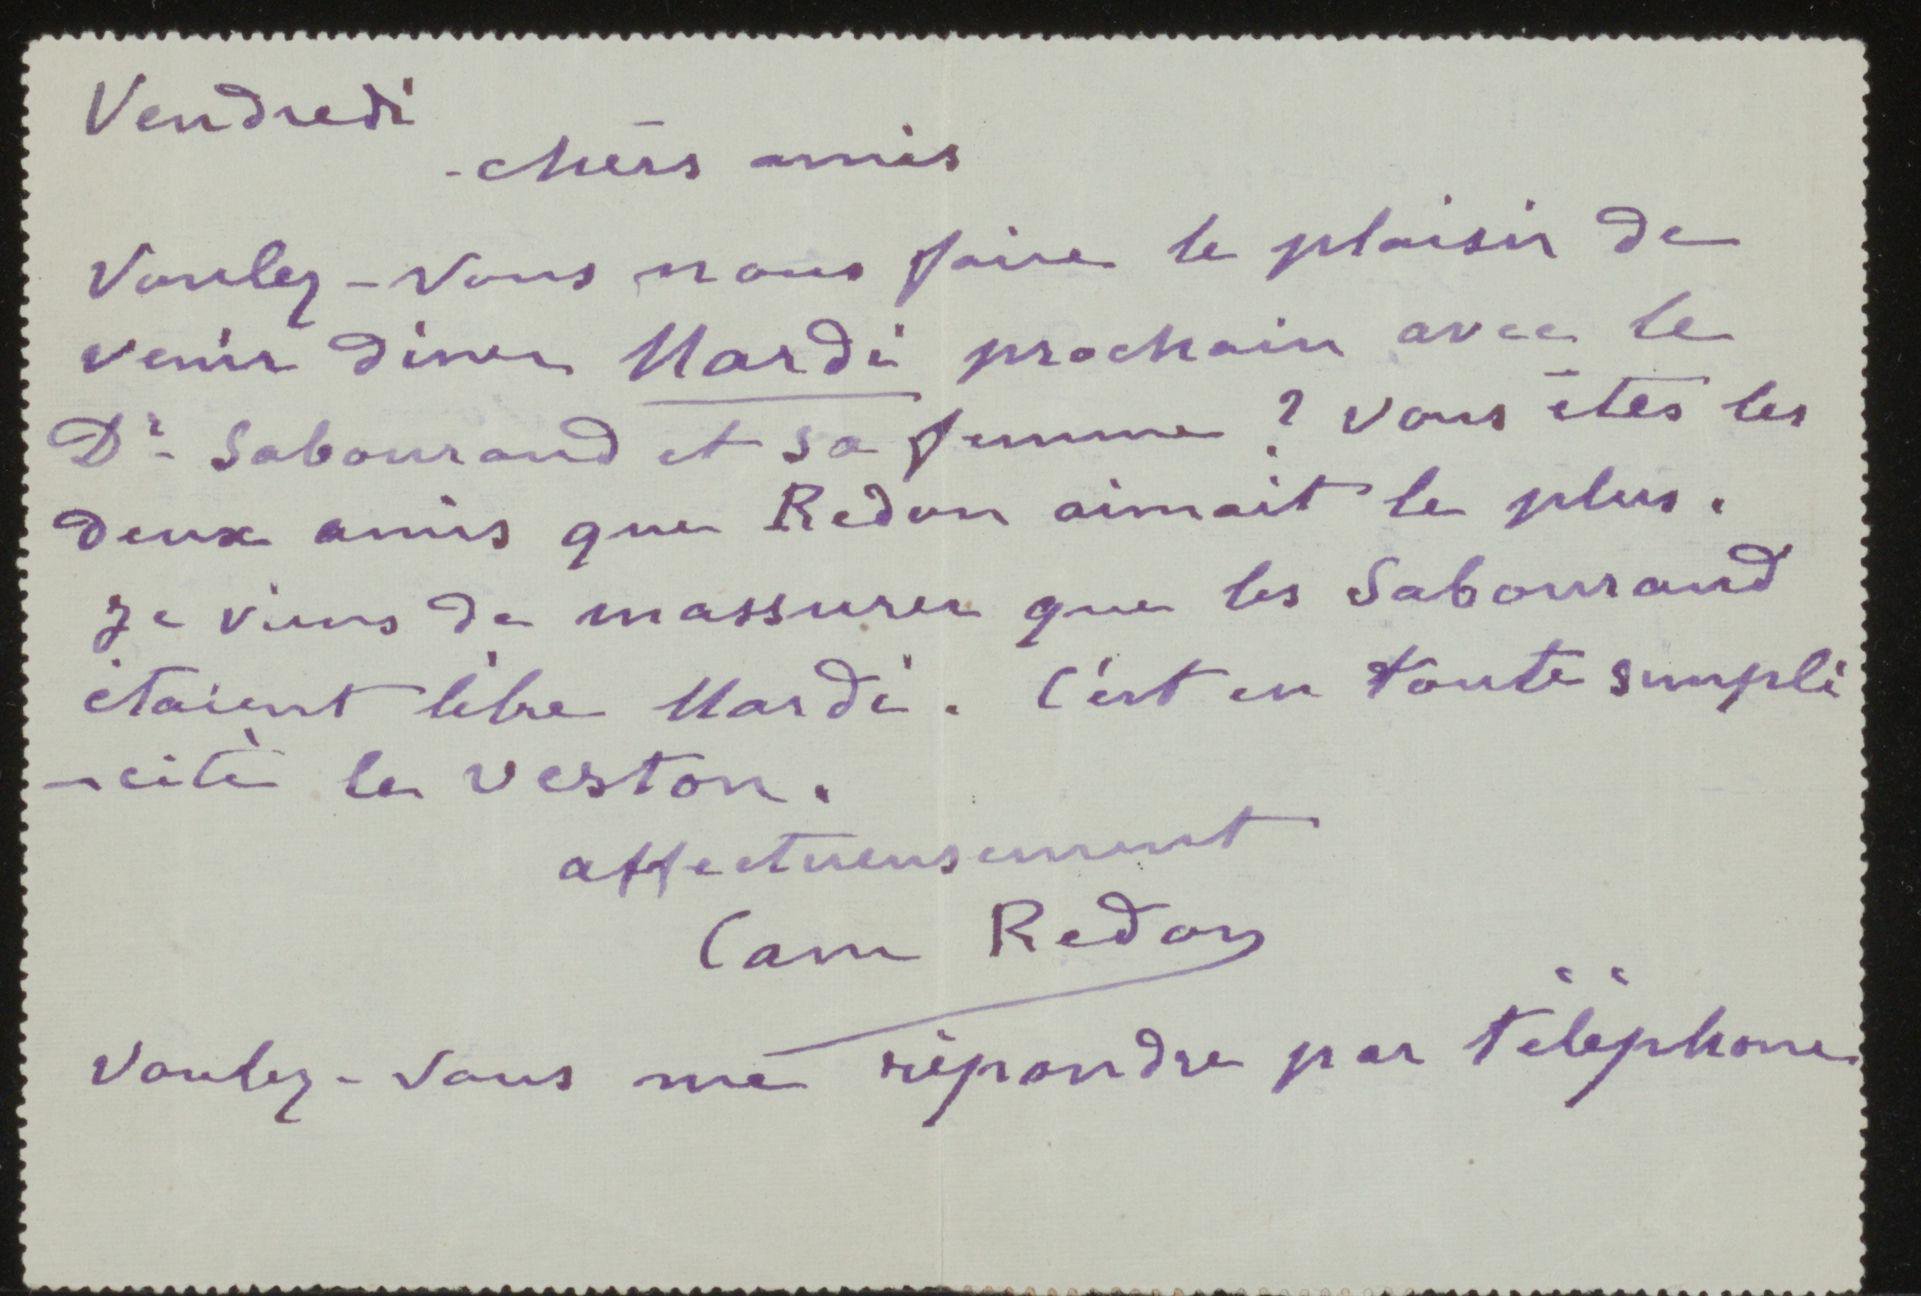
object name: letter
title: Brief aan Andries Bonger en Anne Marie Louise van der Linden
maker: camille redon-falte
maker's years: 1853-1923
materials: ink, paper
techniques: pen, writing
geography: paris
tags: sculptor, painter, odilon redon, amsterdam, andries bonger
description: Brief behoort tot een album samengesteld door weduwe Françoise W.M. Barones van der Borch van Verwolde met afschriften van brieven met betrekking tot (de familie van) Odilon Redon. De brief werd bewaard op pagina 106.